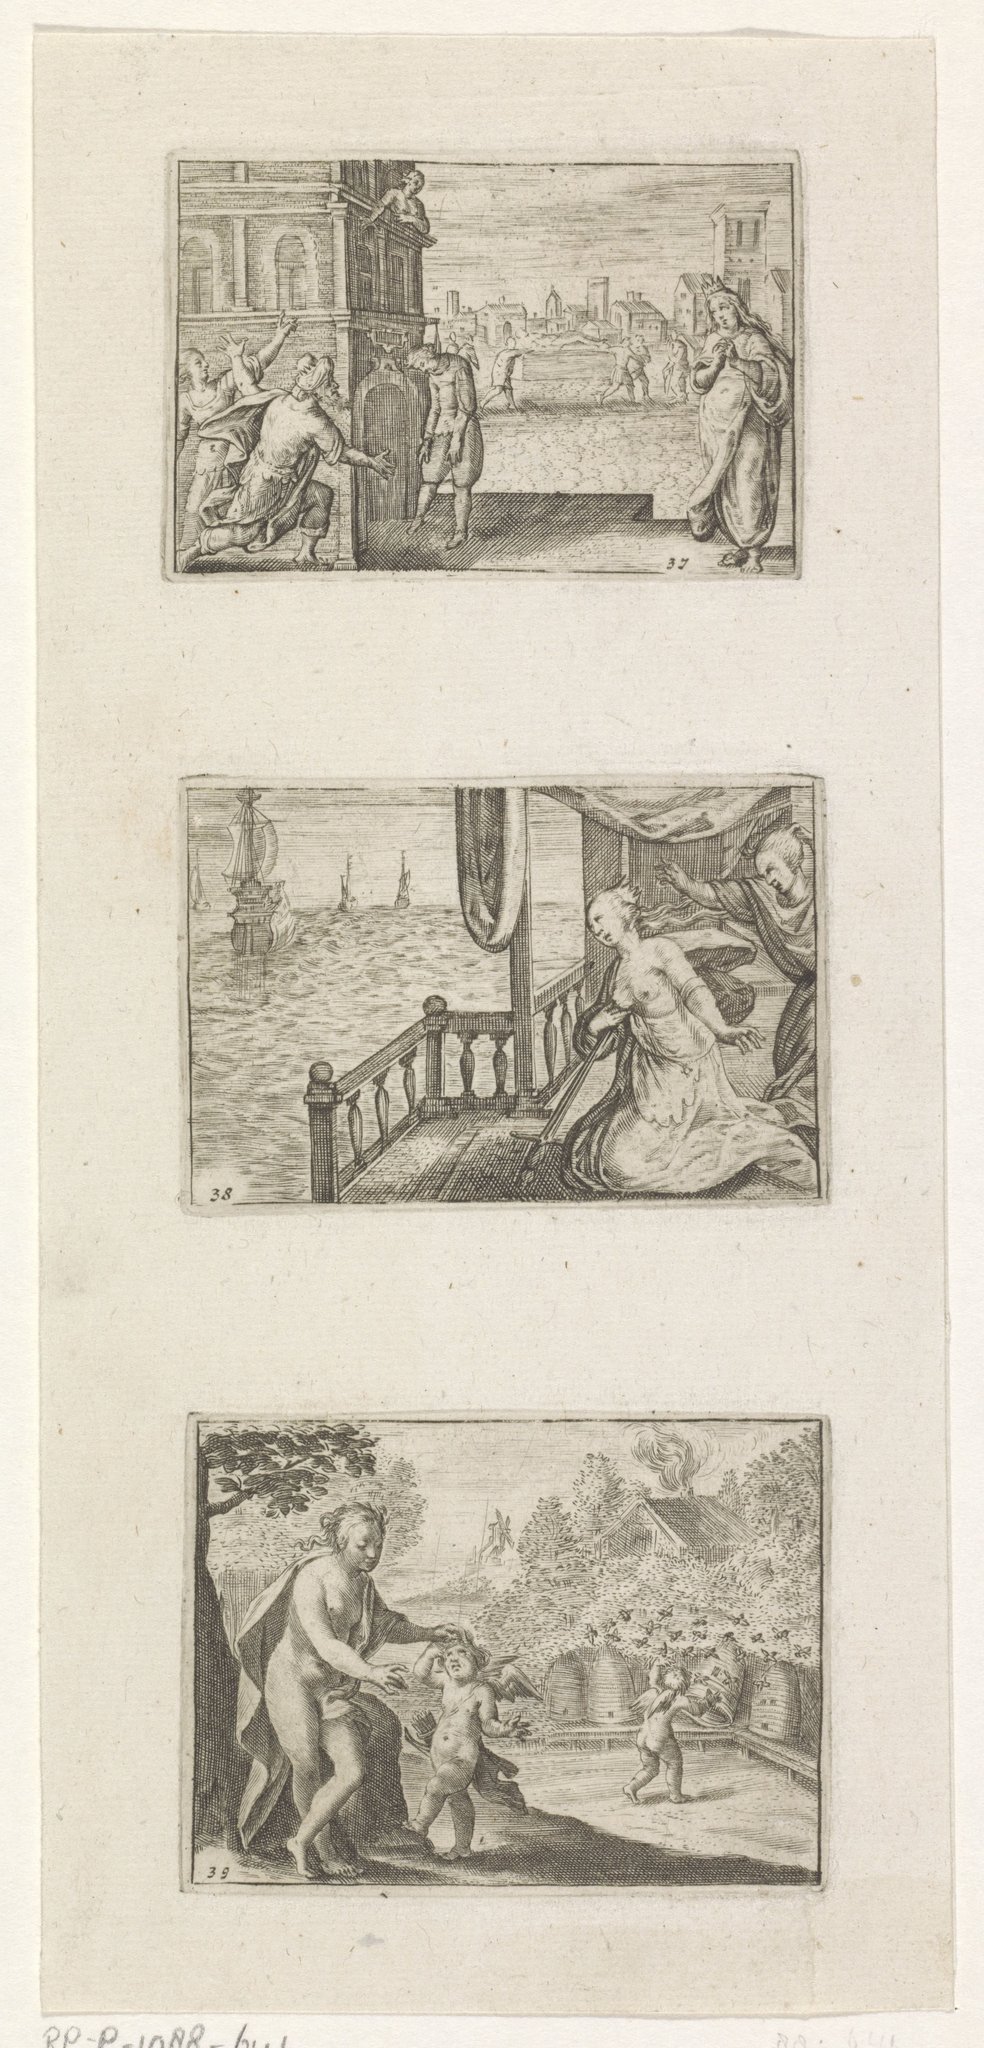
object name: print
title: Anaxarete en Iphis / Dood van Dido / Venus troost Amor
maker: monogrammist mp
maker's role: print maker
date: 1680-1800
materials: paper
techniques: engraving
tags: death of iphis, a youth of salamis: desperate for the love of anaxarete he hangs himself at her door, crying cupid, surrounded by bees, runs or clings to his mother venus to be soothed, death of dido; she climbs the funeral pyre and falls upon the sword of aeneas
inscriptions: collector's mark: Lugt 2228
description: Drie voorstellingen op een blad. Boven: Iphis heeft zichzelf opgehangen voor de deur van de vrouw van wie hij hield, Anaxarete. Zij minachtte hem. Anaxarete kijkt toe vanaf het balkon. Op de achtergrond wordt het lichaam van Iphis weggedragen. Midden: Dido doodt zichzelf met Aeneas' zwaard. Op zee de vertrekkende schepen van Aeneas. Onder: Amor laat zich toosten door Venus, nadat hij door bijen gestoken is.